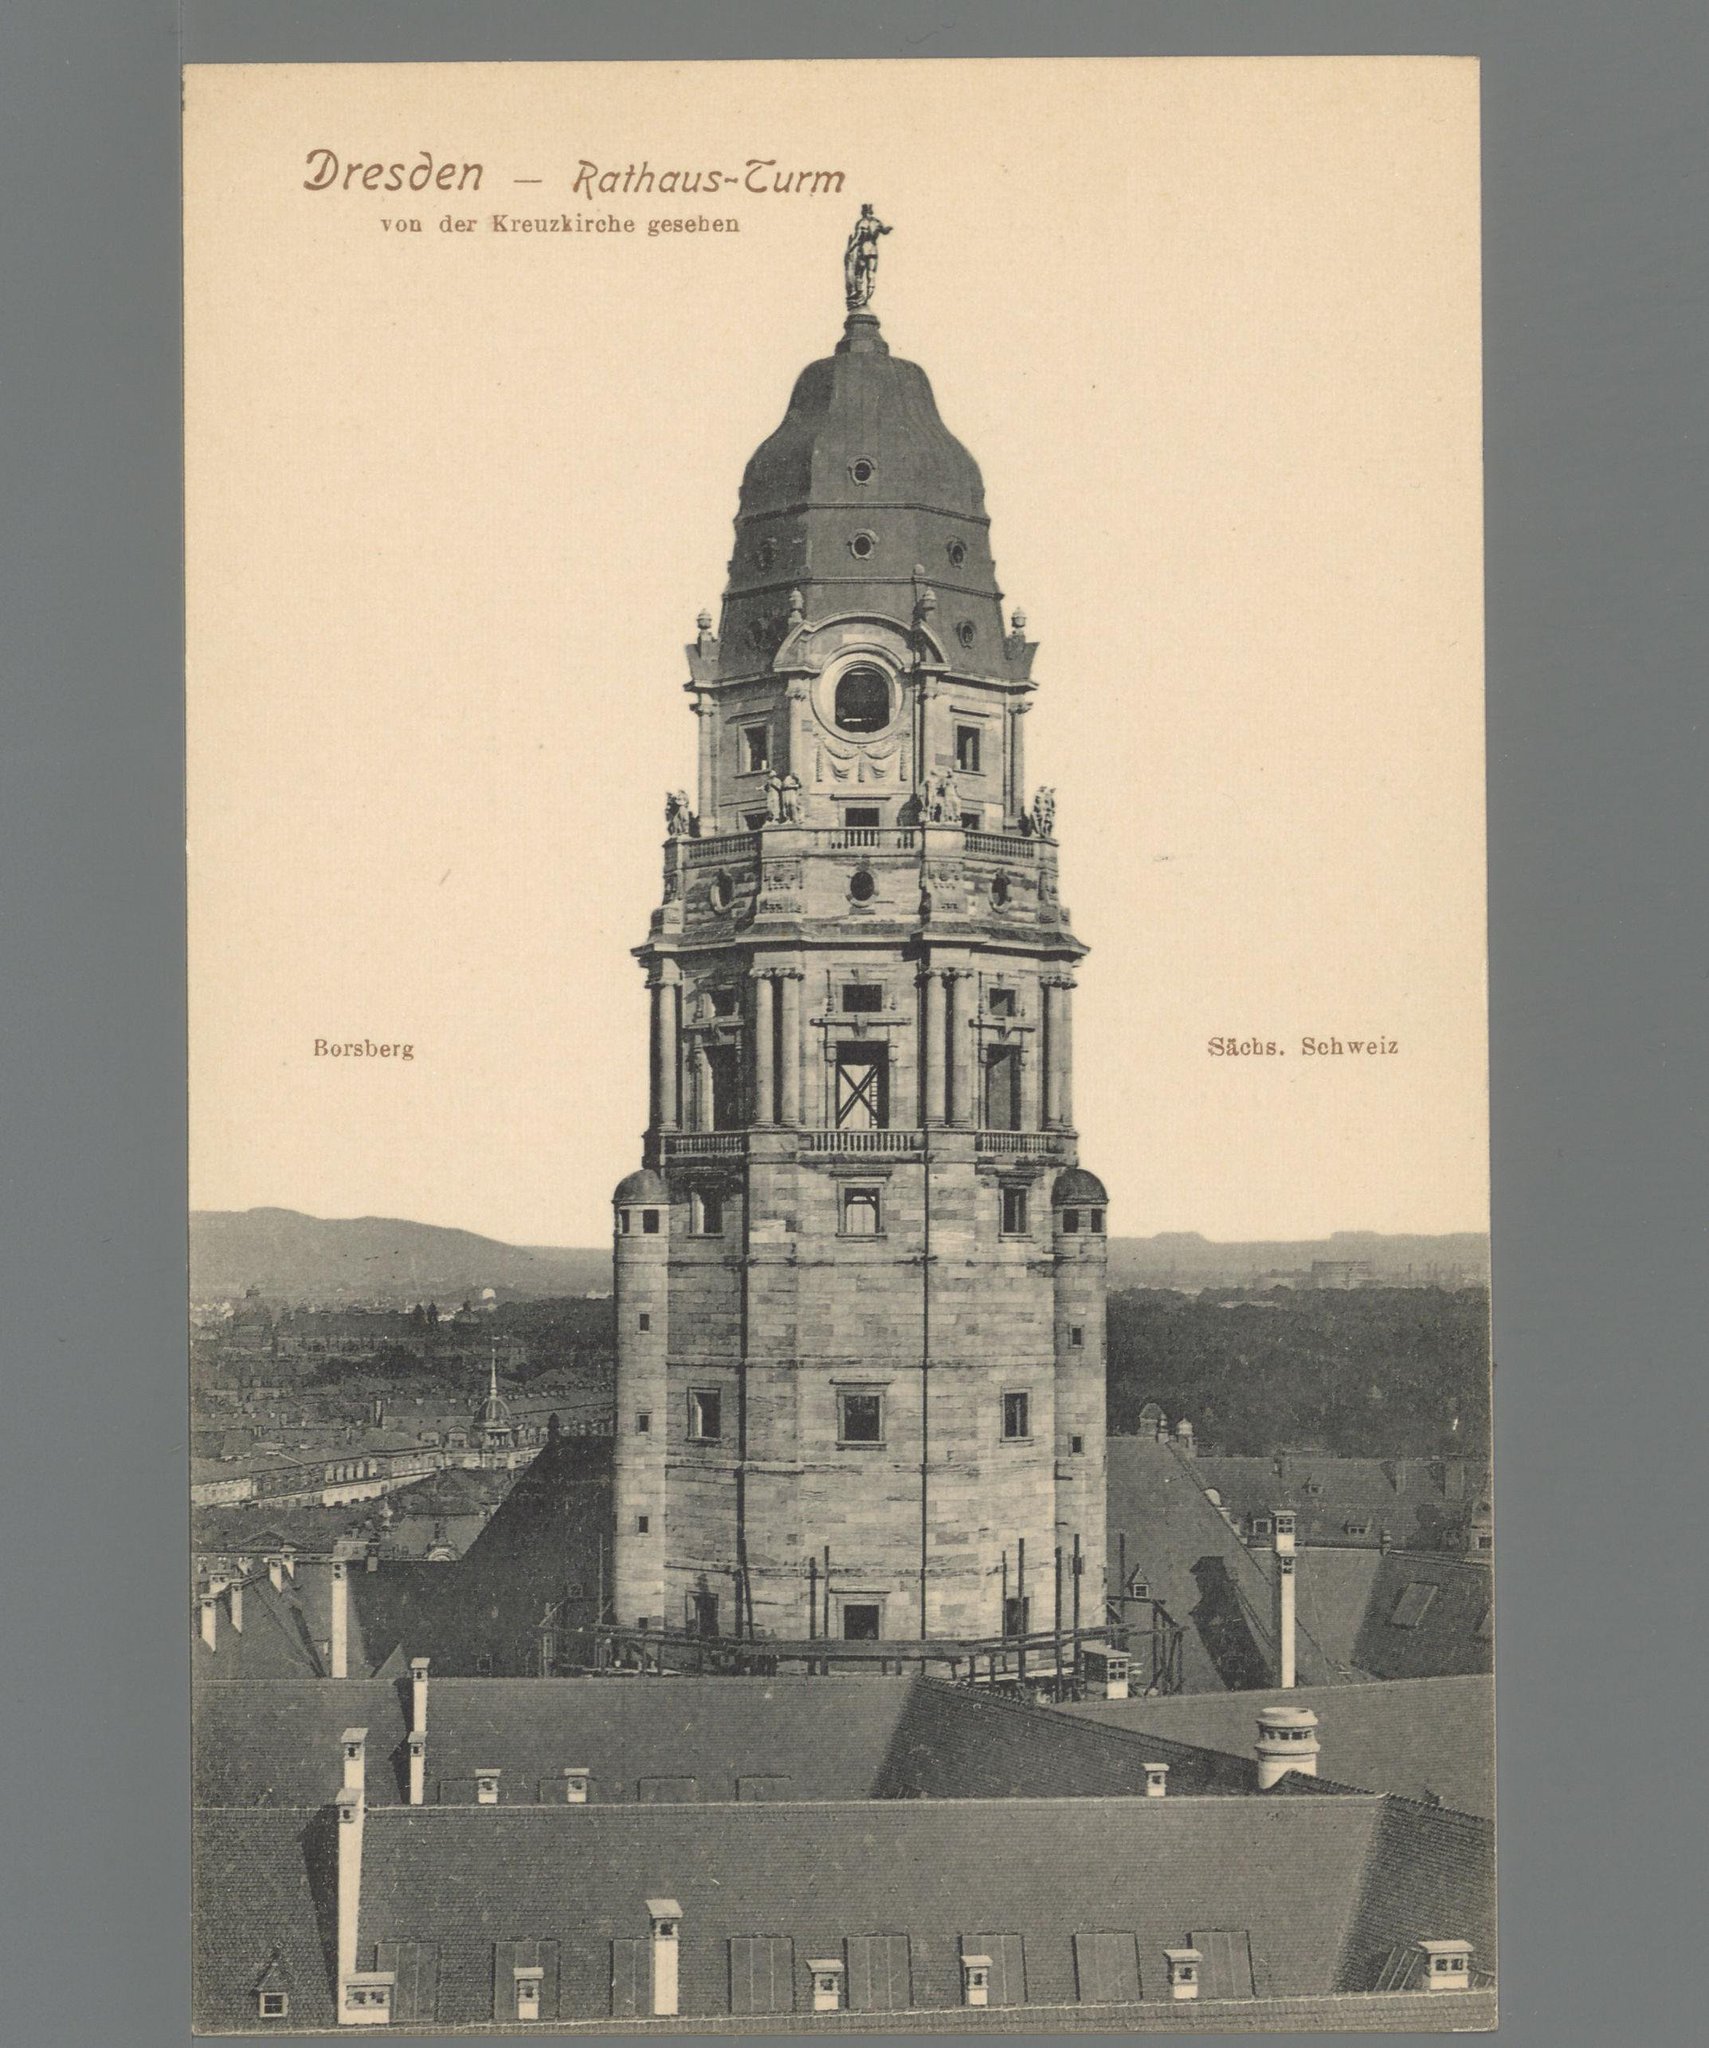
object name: photomechanical print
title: Dresden - Rathaus-Turm, von der Kreuzkirche gesehen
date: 1905-1930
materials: cardboard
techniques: photograph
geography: dresden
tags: townhall